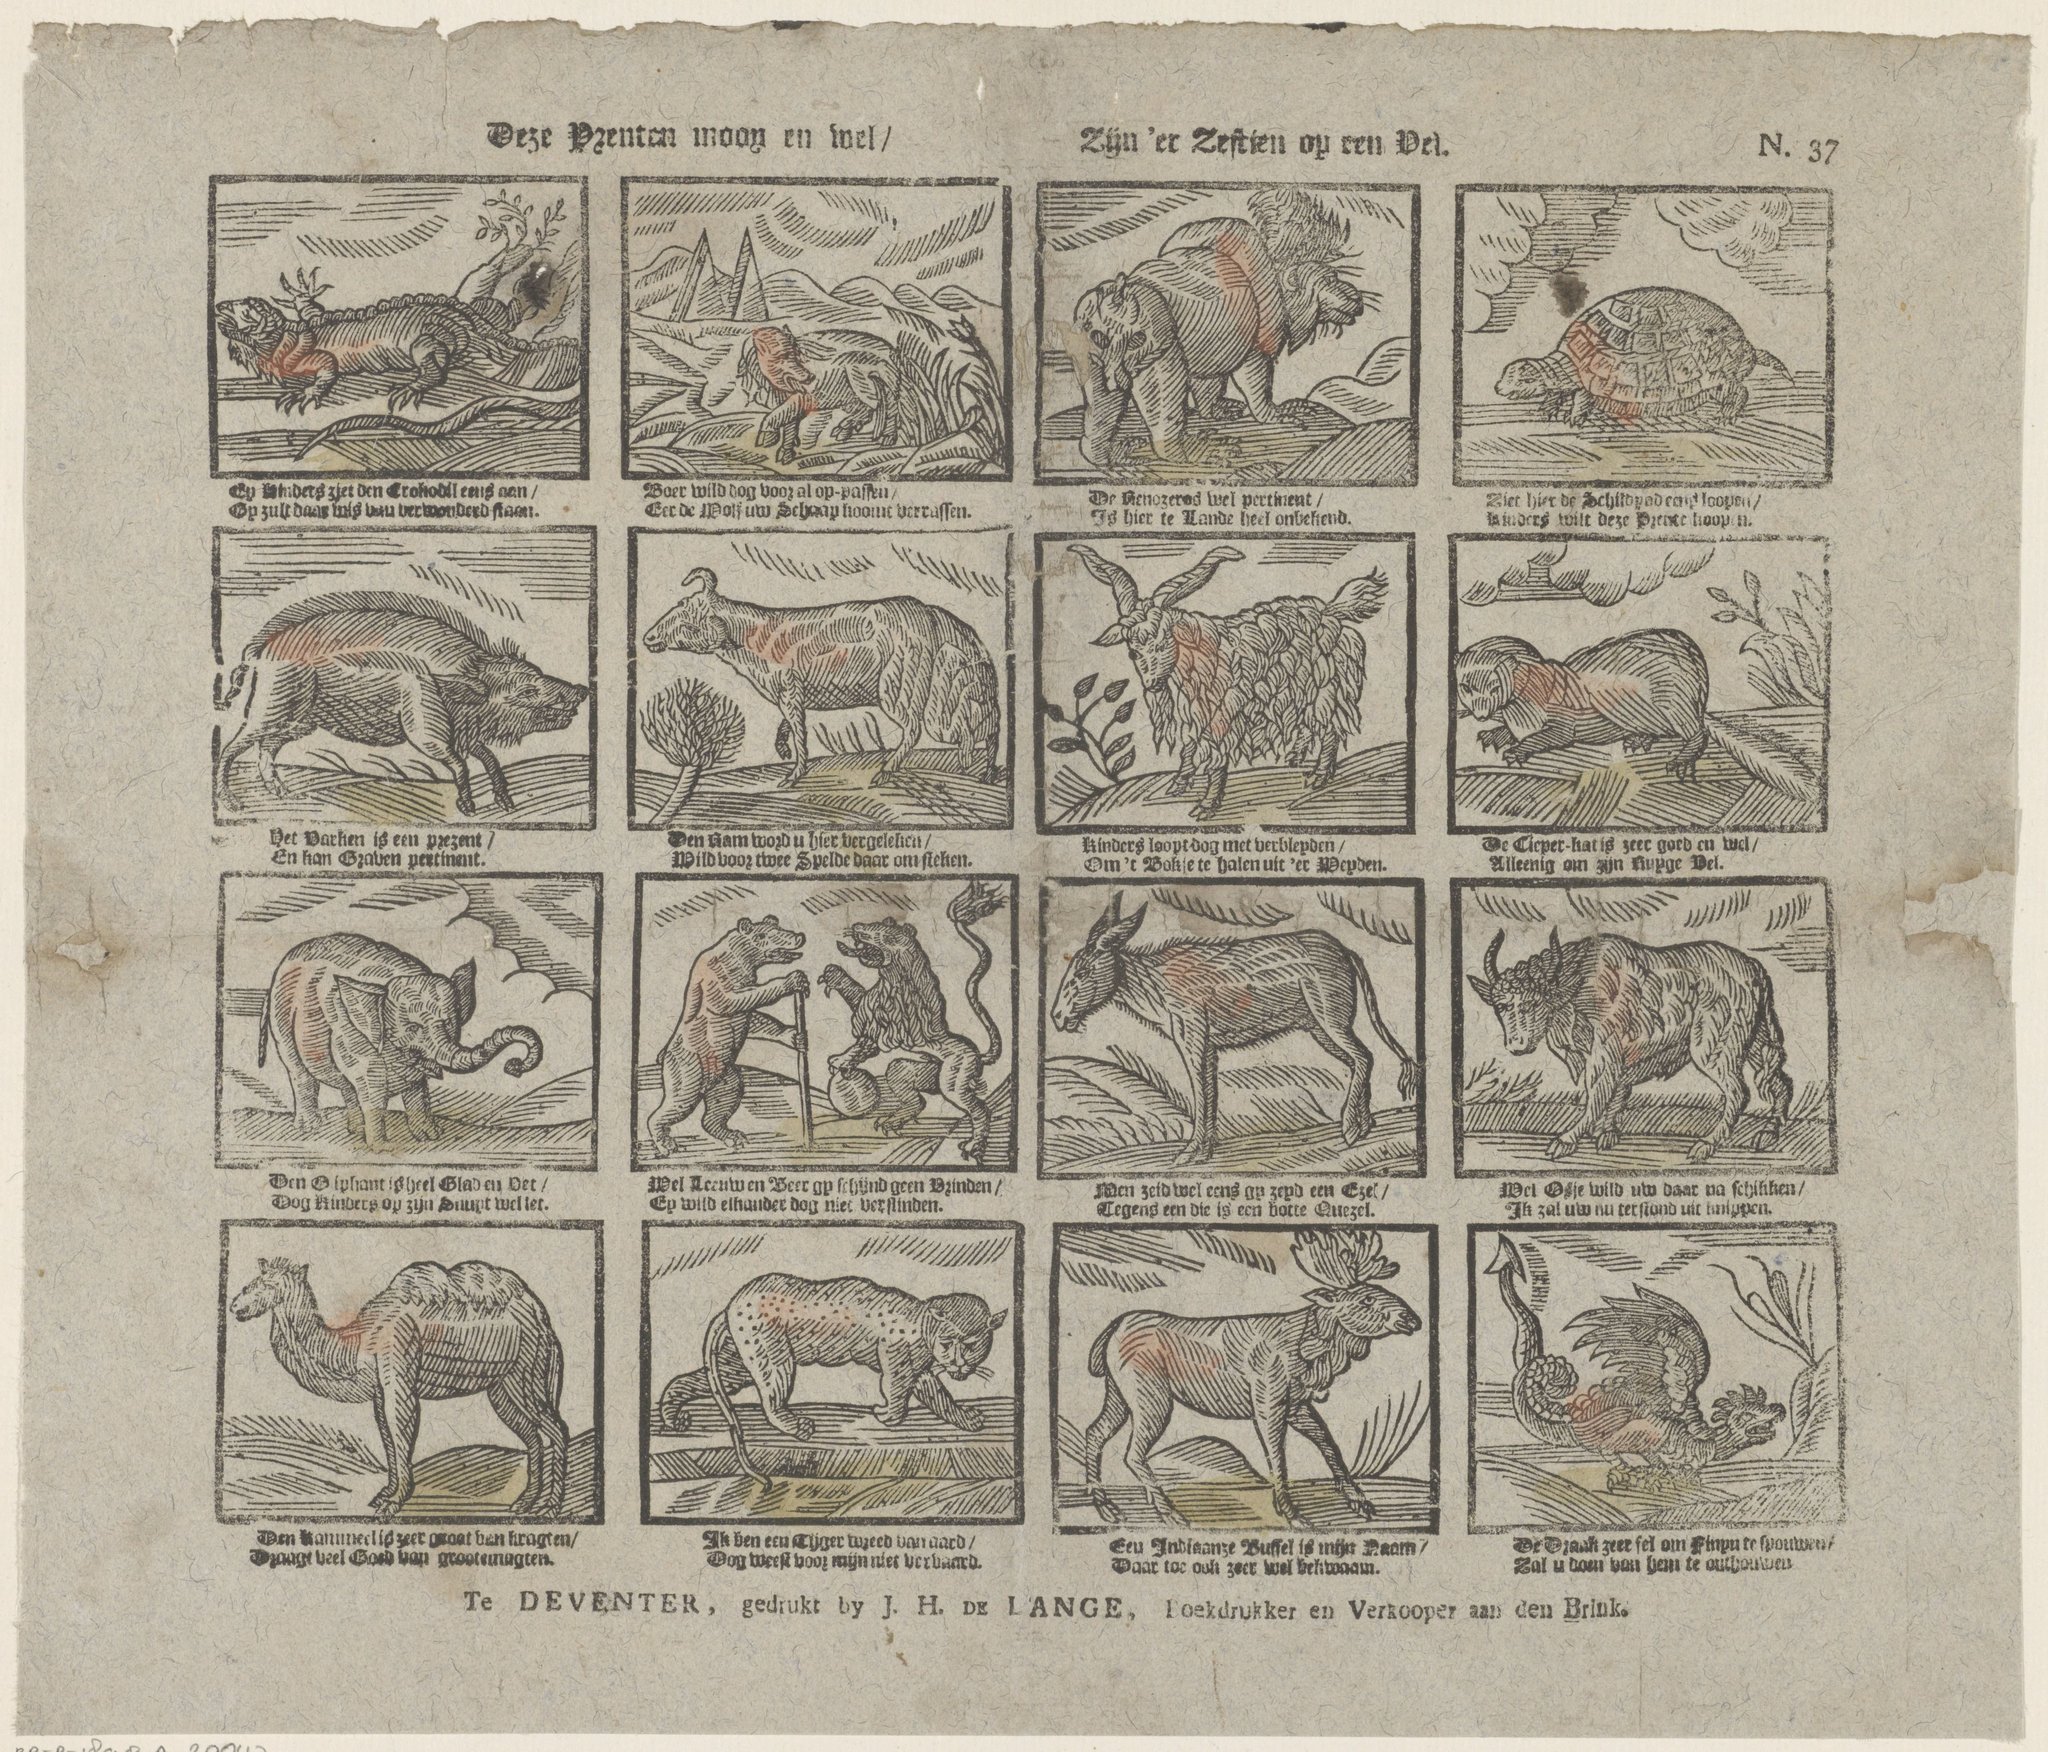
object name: print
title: Deze prenten mooy en wel / Zijn 'er zestien op een vel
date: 1787-1822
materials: paper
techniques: colour, letterpress printing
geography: deventer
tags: animals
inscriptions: collector's mark: Lugt 2166, inscription: ‘Jakon [...] 1820’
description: Blad met 16 voorstellingen van verschillende dieren, zoals krokodil, een olifant een eland en een draak. Onder elke afbeelding een tweeregelig vers. Genummerd rechtsboven: N. 37.